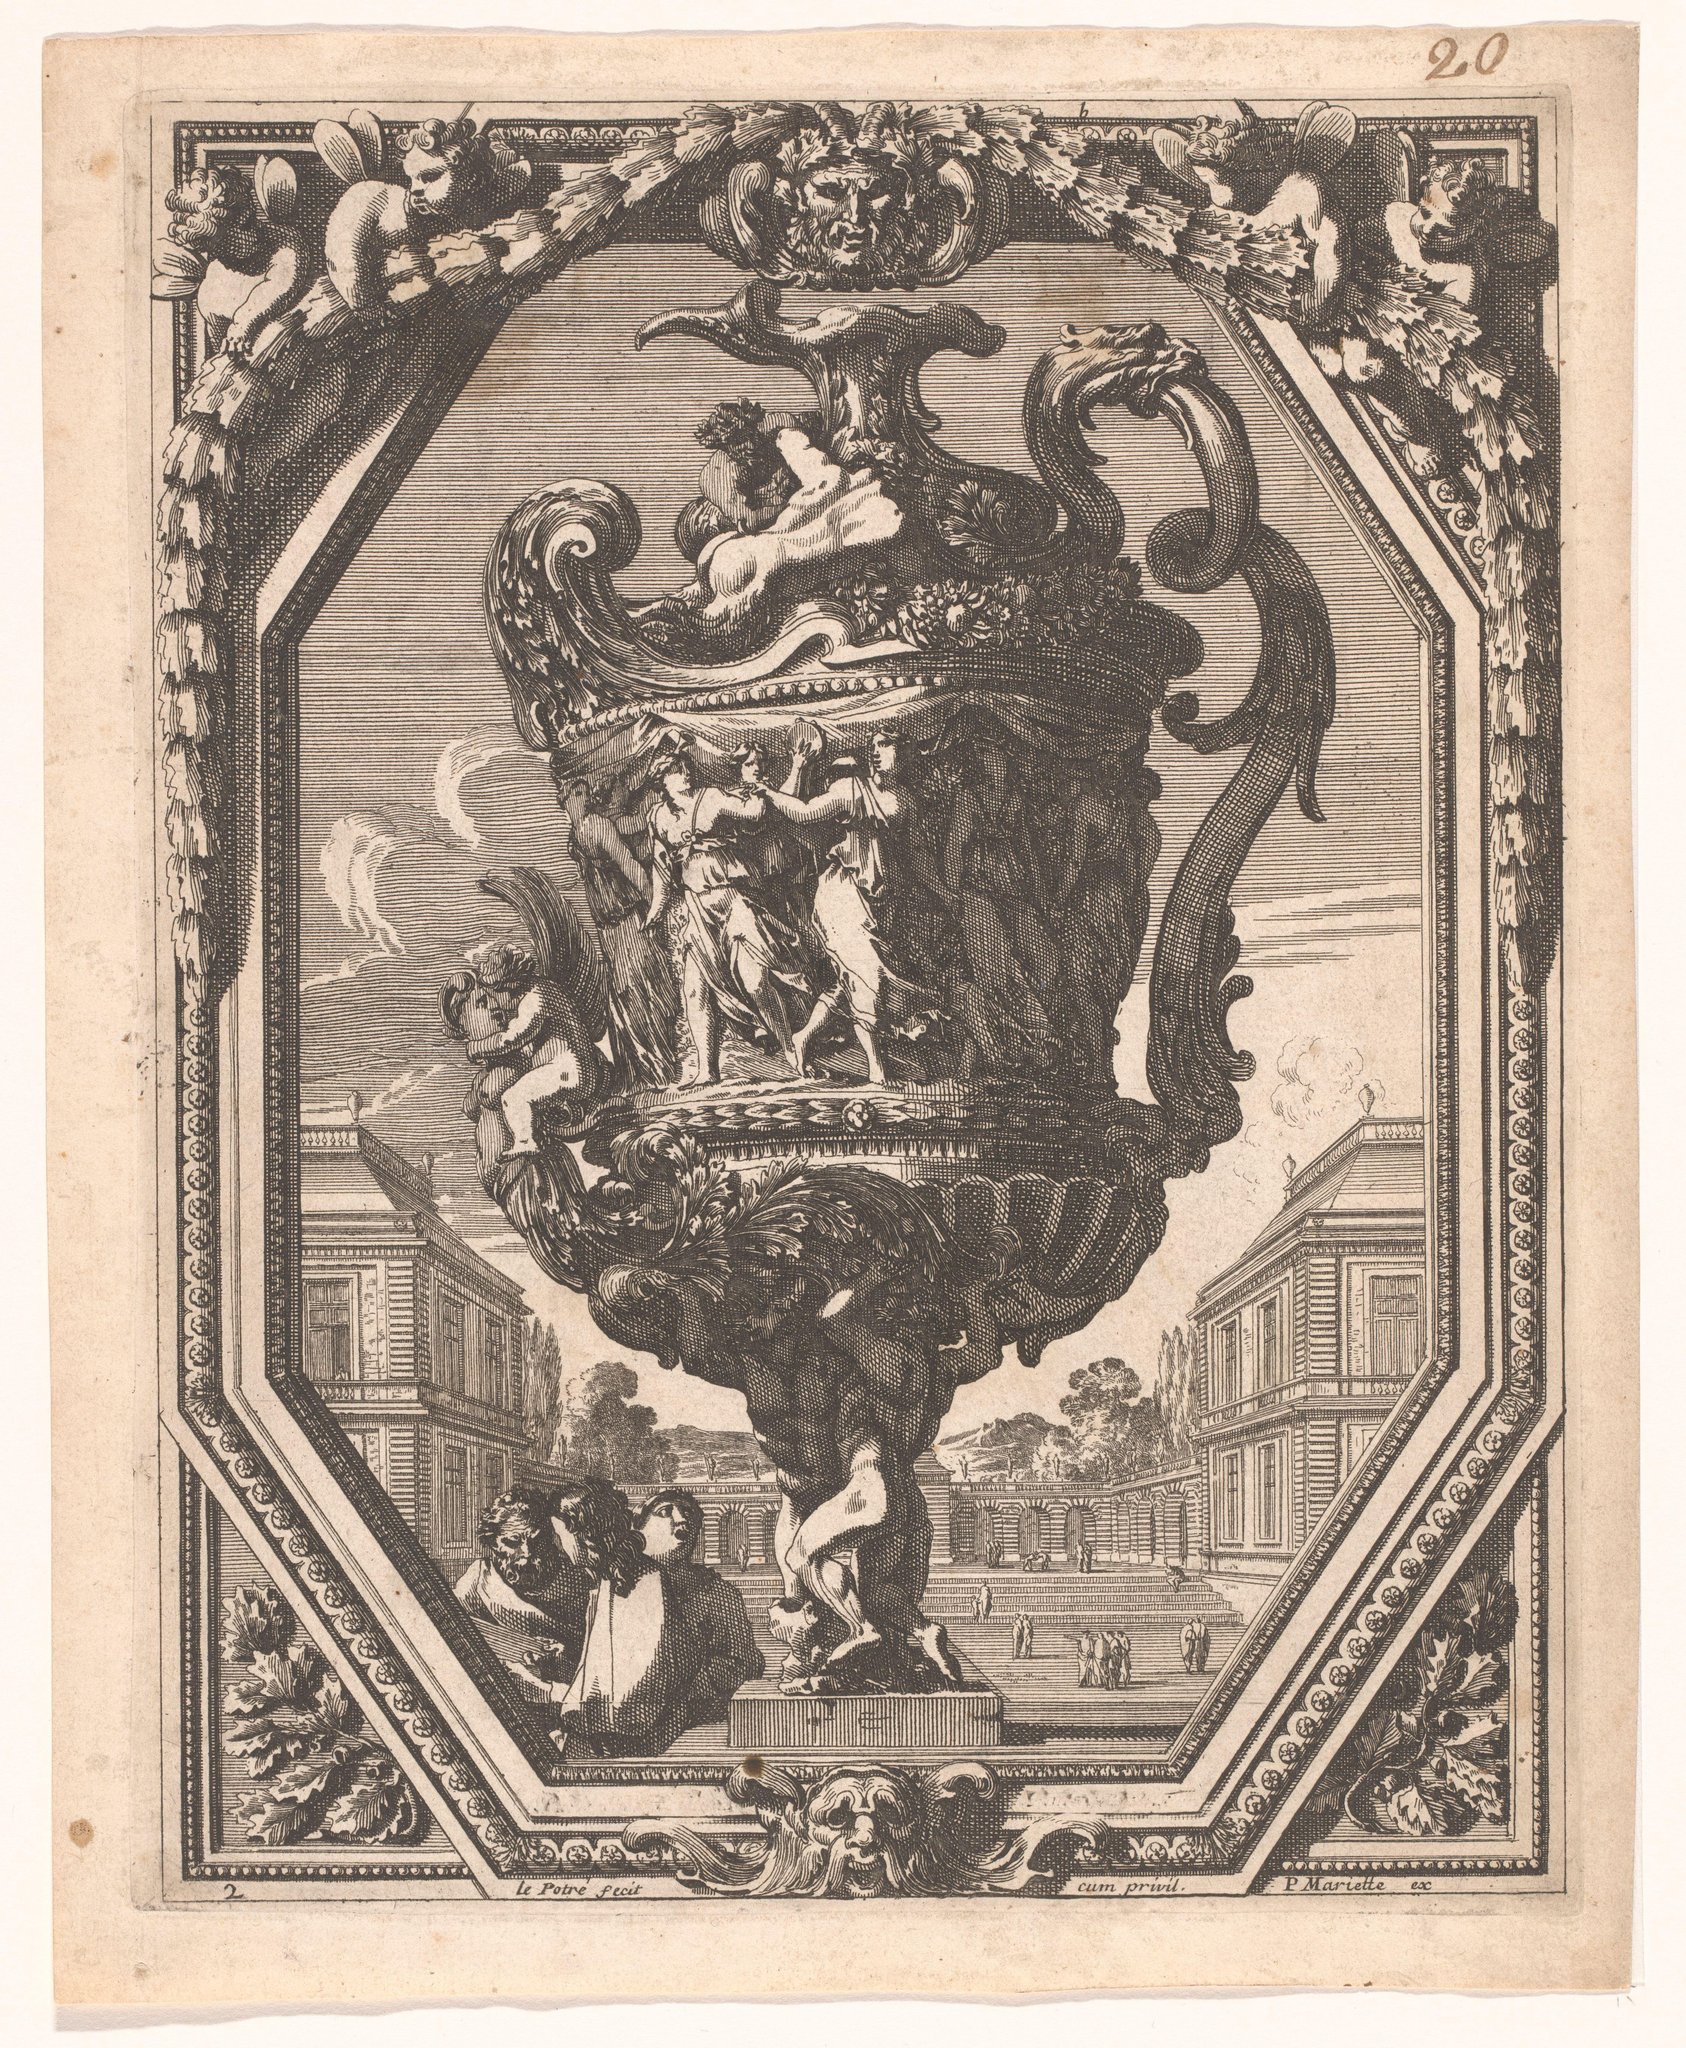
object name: print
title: Schenkkan met dansende vrouwen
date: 1664-1716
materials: paper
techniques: etching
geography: paris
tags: vase ~ ornament, group dancing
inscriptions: collector's mark: Lugt 2228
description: Een geornamenteerde schenkkan met een fries met dansende en musicerende vrouwen. De voet wordt gevormd door twee mannen die de kan dragen. De kan is gevat in een ornamentele omlijsting met putti. Midden boven genummerd b.